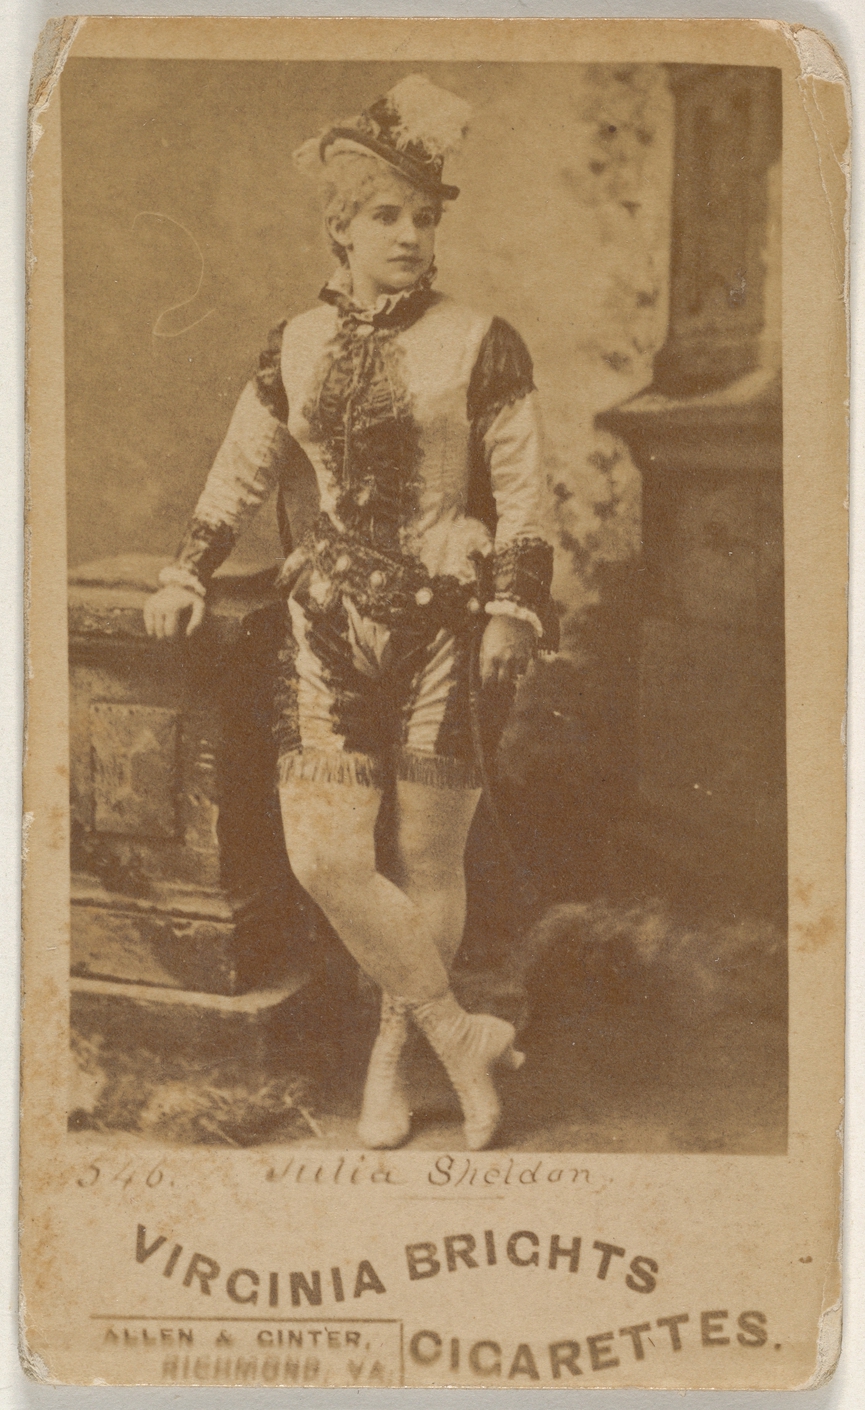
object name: photograph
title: Card 546, Julia Sheldon, from the Actors and Actresses series (N45, Type 6) for Virginia Brights Cigarettes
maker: allen & ginter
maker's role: publisher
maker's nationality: american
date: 1888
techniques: albumen silver print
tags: portraits,women,actresses